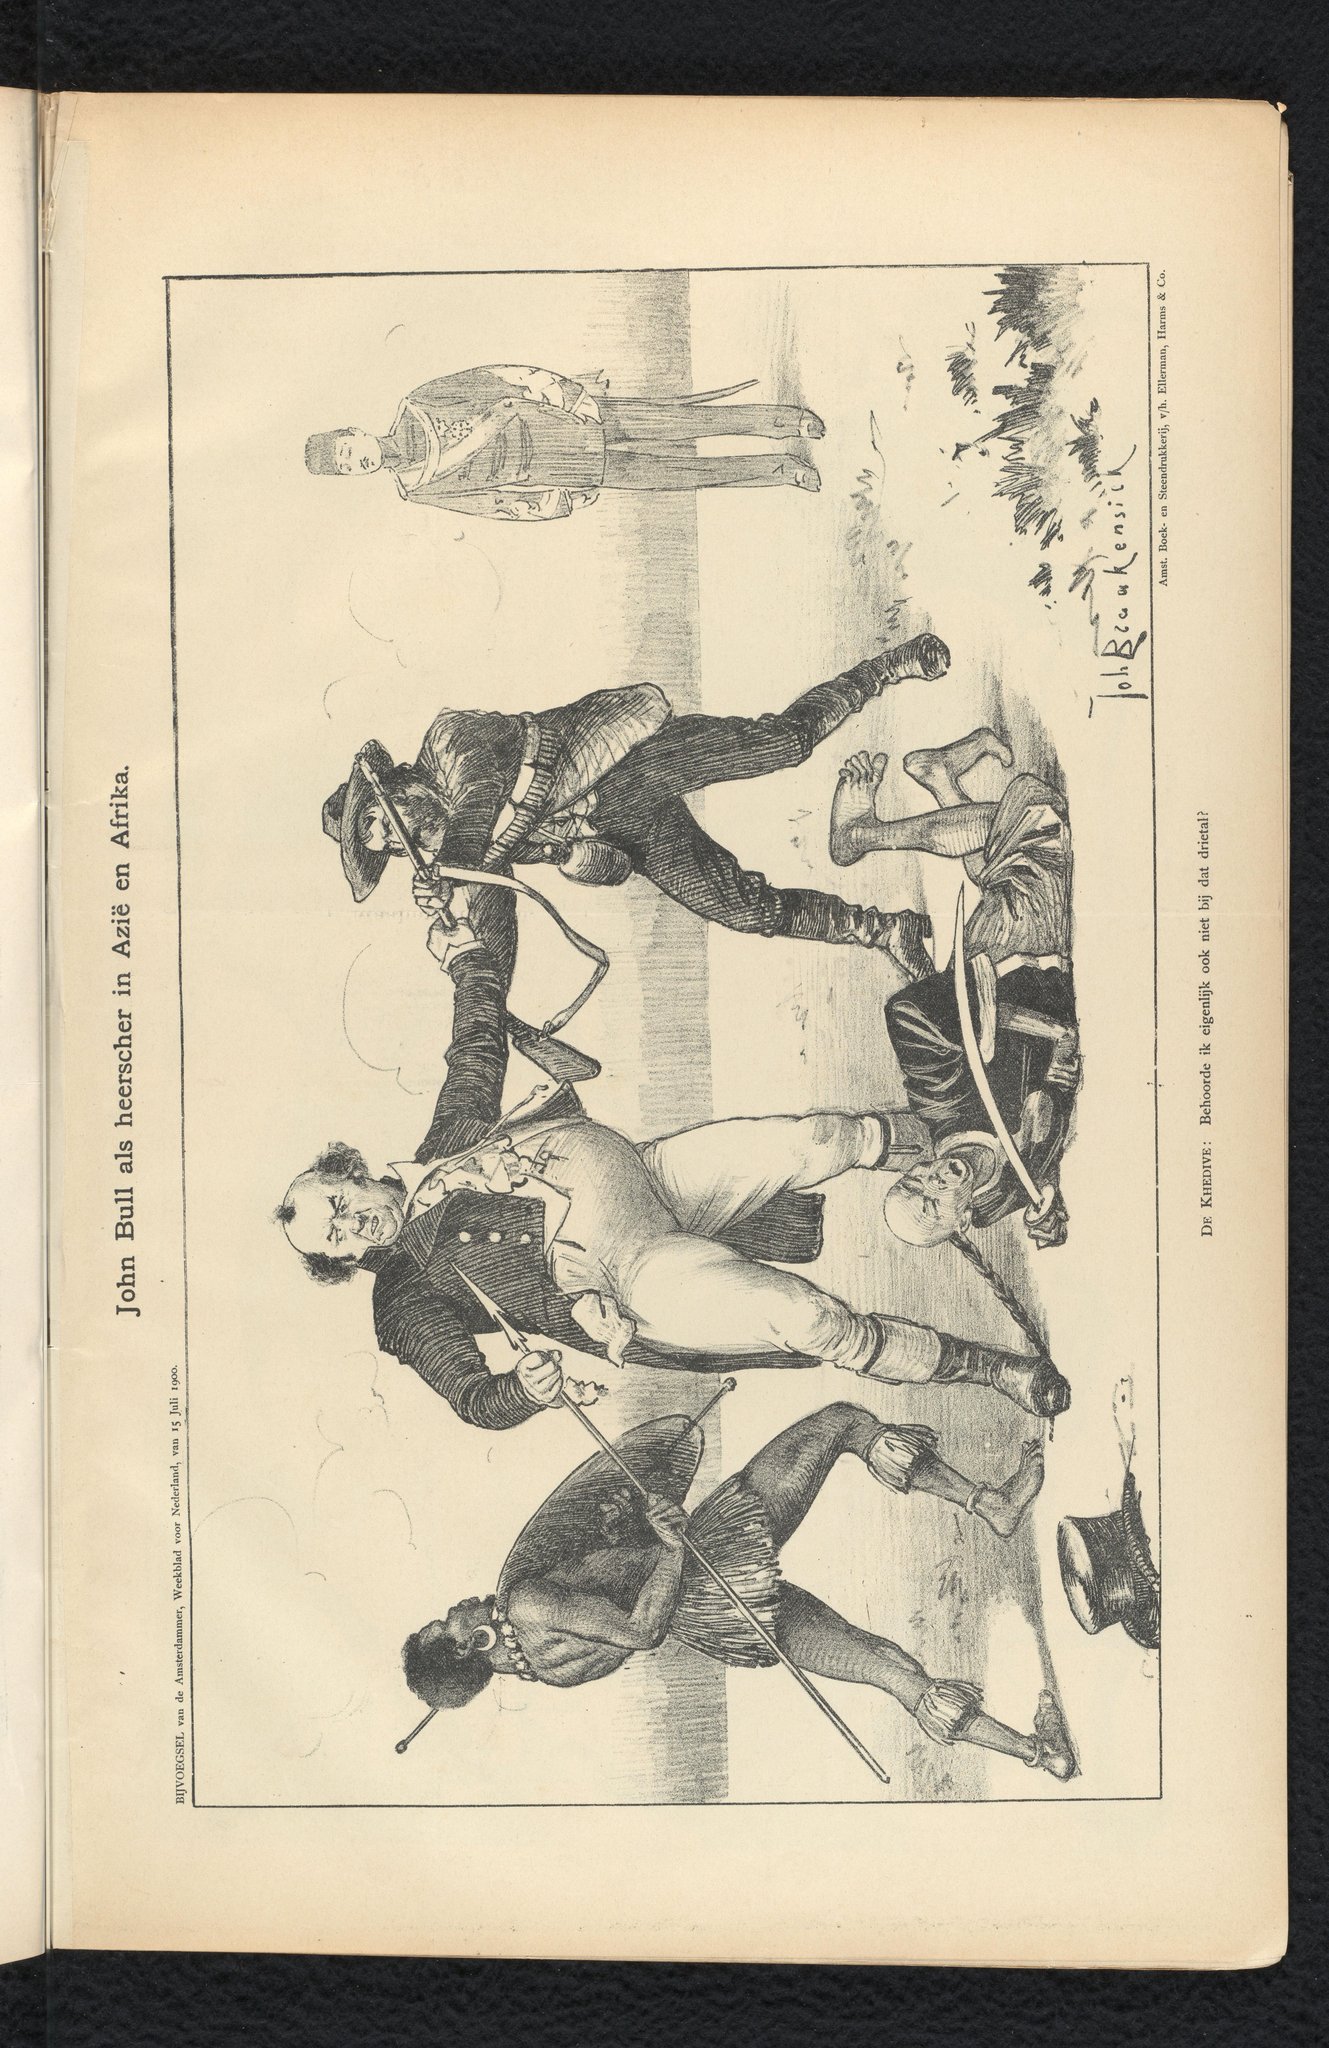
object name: cartoon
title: John Bull als heerscher in Azië en Afrika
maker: johan braakensiek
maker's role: draughtsman, print maker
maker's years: 1858-1940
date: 1900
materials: paper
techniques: lithograph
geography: amsterdam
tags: personifications of countries, nations, states, districts, etc., hand-to-hand fighting (~ battle), political caricatures and satires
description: John Bull (Engeland) verwikkeld in een strijd met drie vijanden, een Afrikaan, een Boer en een Chinees. Rechts kijkt Abbas II, kedive of onderkoning van Egypte toe.